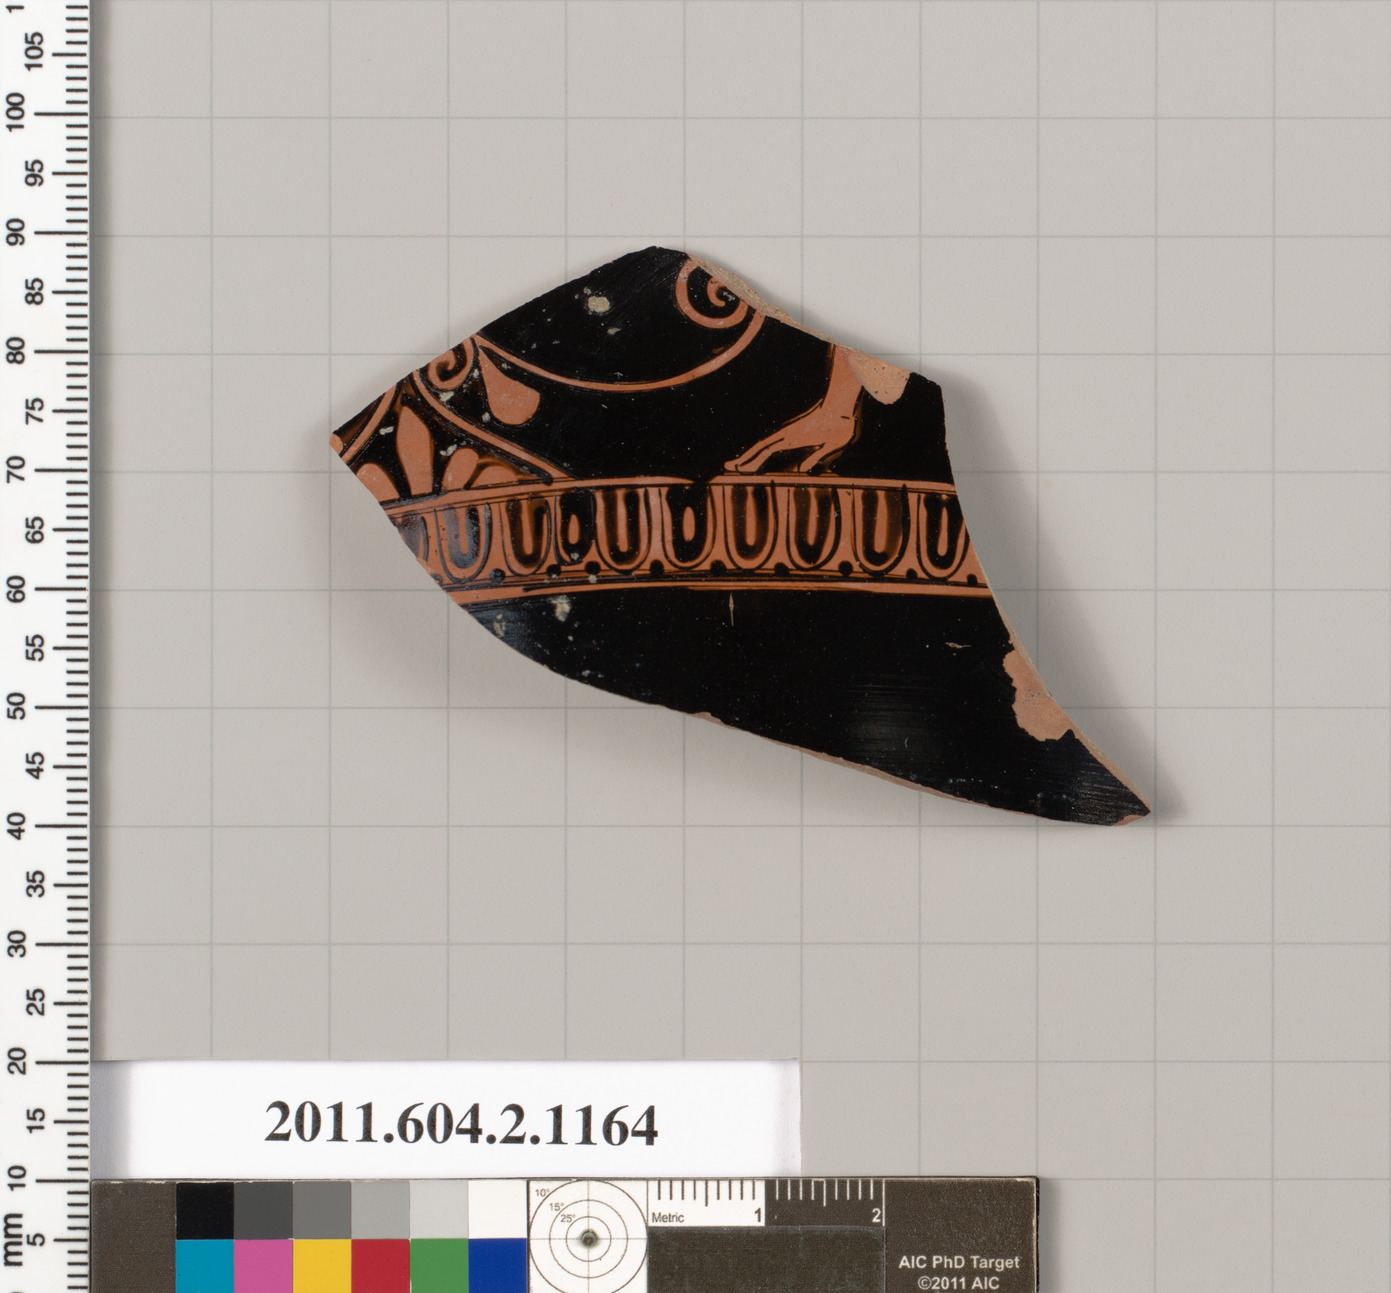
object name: skyphos fragment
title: Terracotta fragment of a skyphos (deep drinking cup)?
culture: greek, attic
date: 475-451 BCE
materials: terracotta